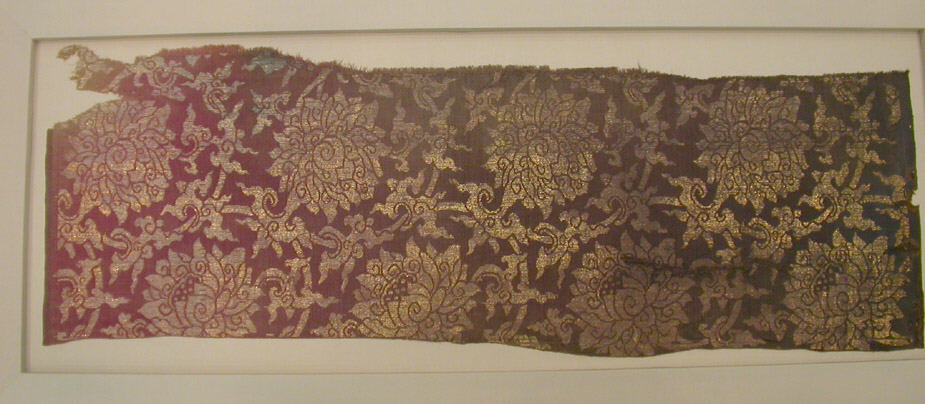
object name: piece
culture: chinese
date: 1701-1733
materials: metal thread, silk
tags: flowers